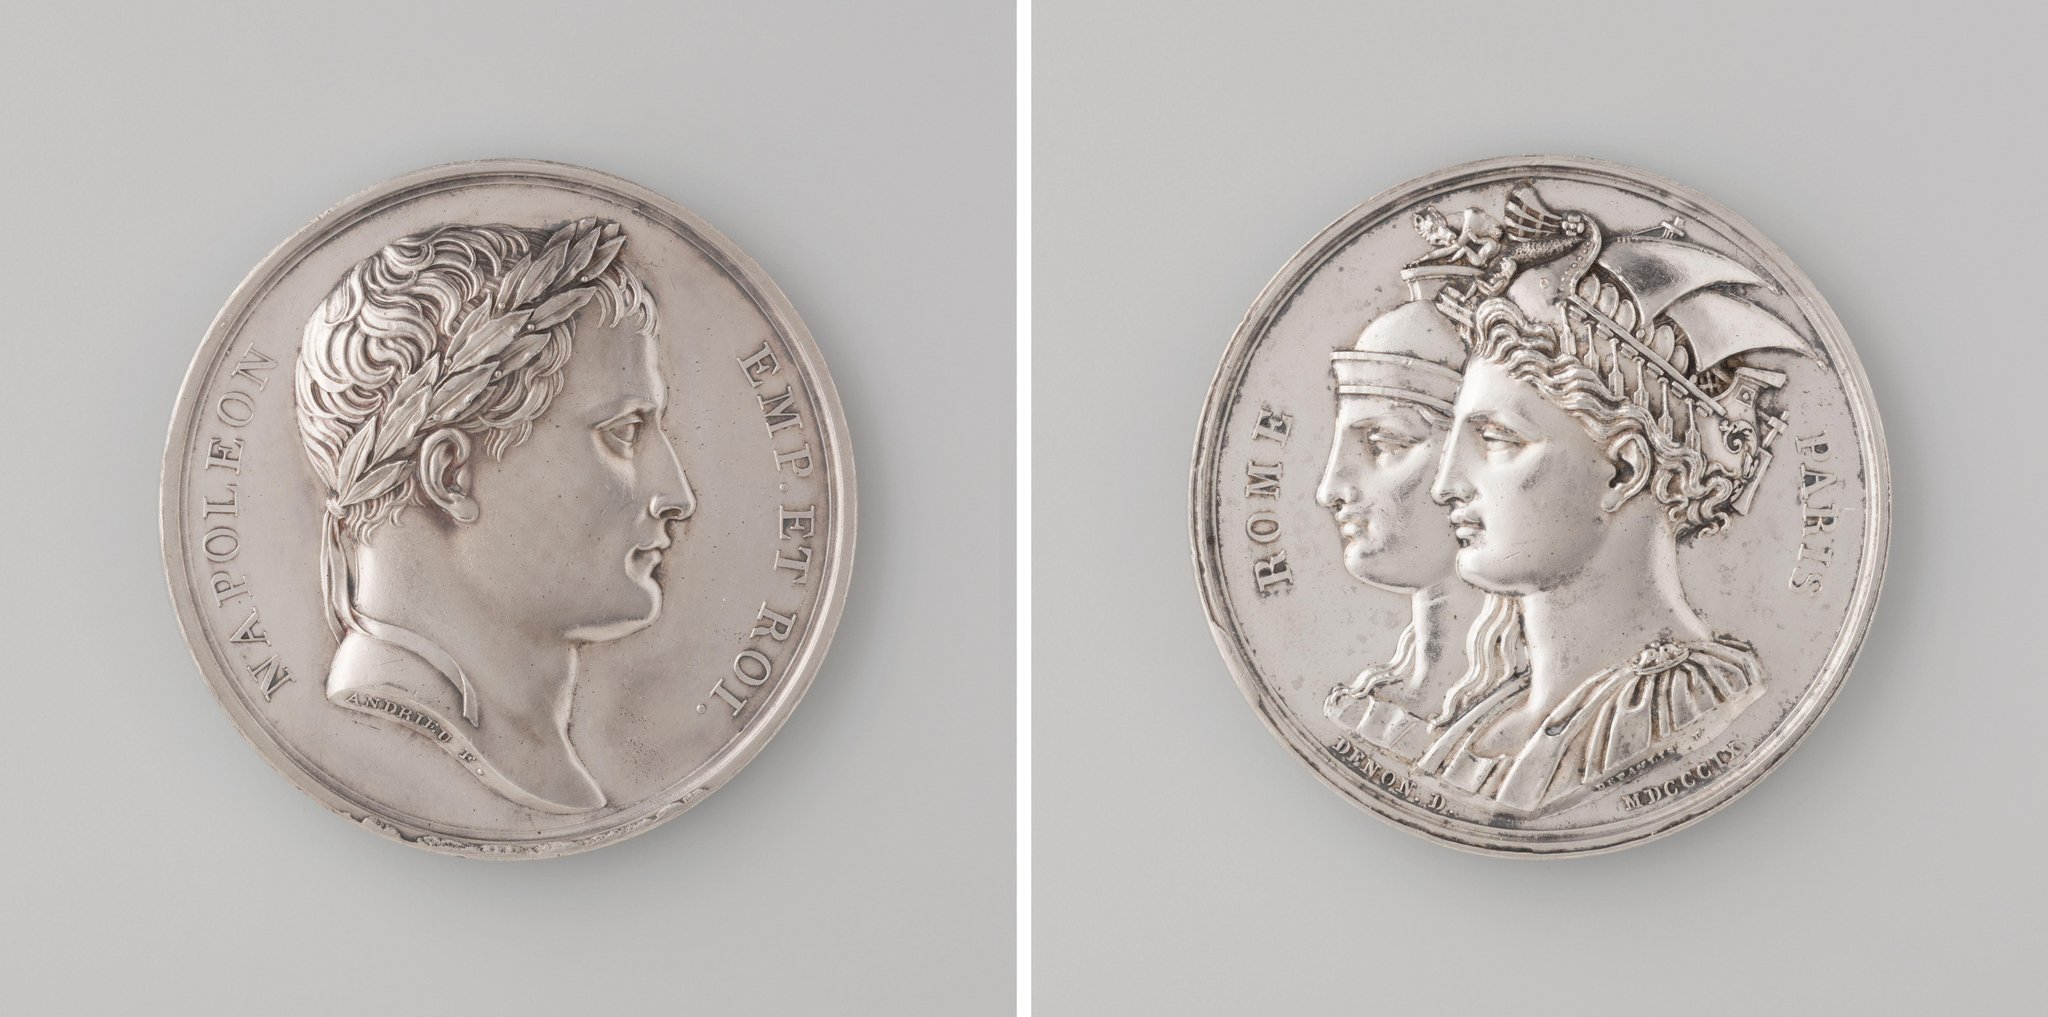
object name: history medal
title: Napoleon Bonaparte, keizer der Fransen, heerser over Parijs en Rome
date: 1809-1815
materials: silver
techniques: striking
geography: paris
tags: napoleon i (emperor of the french), paris, rome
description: Zilveren penning. Voorzijde: borststuk man met lauwerkrans binnen omschrift. Keerzijde: borststukken van twee gehelmde vrouwen binnen omschrift